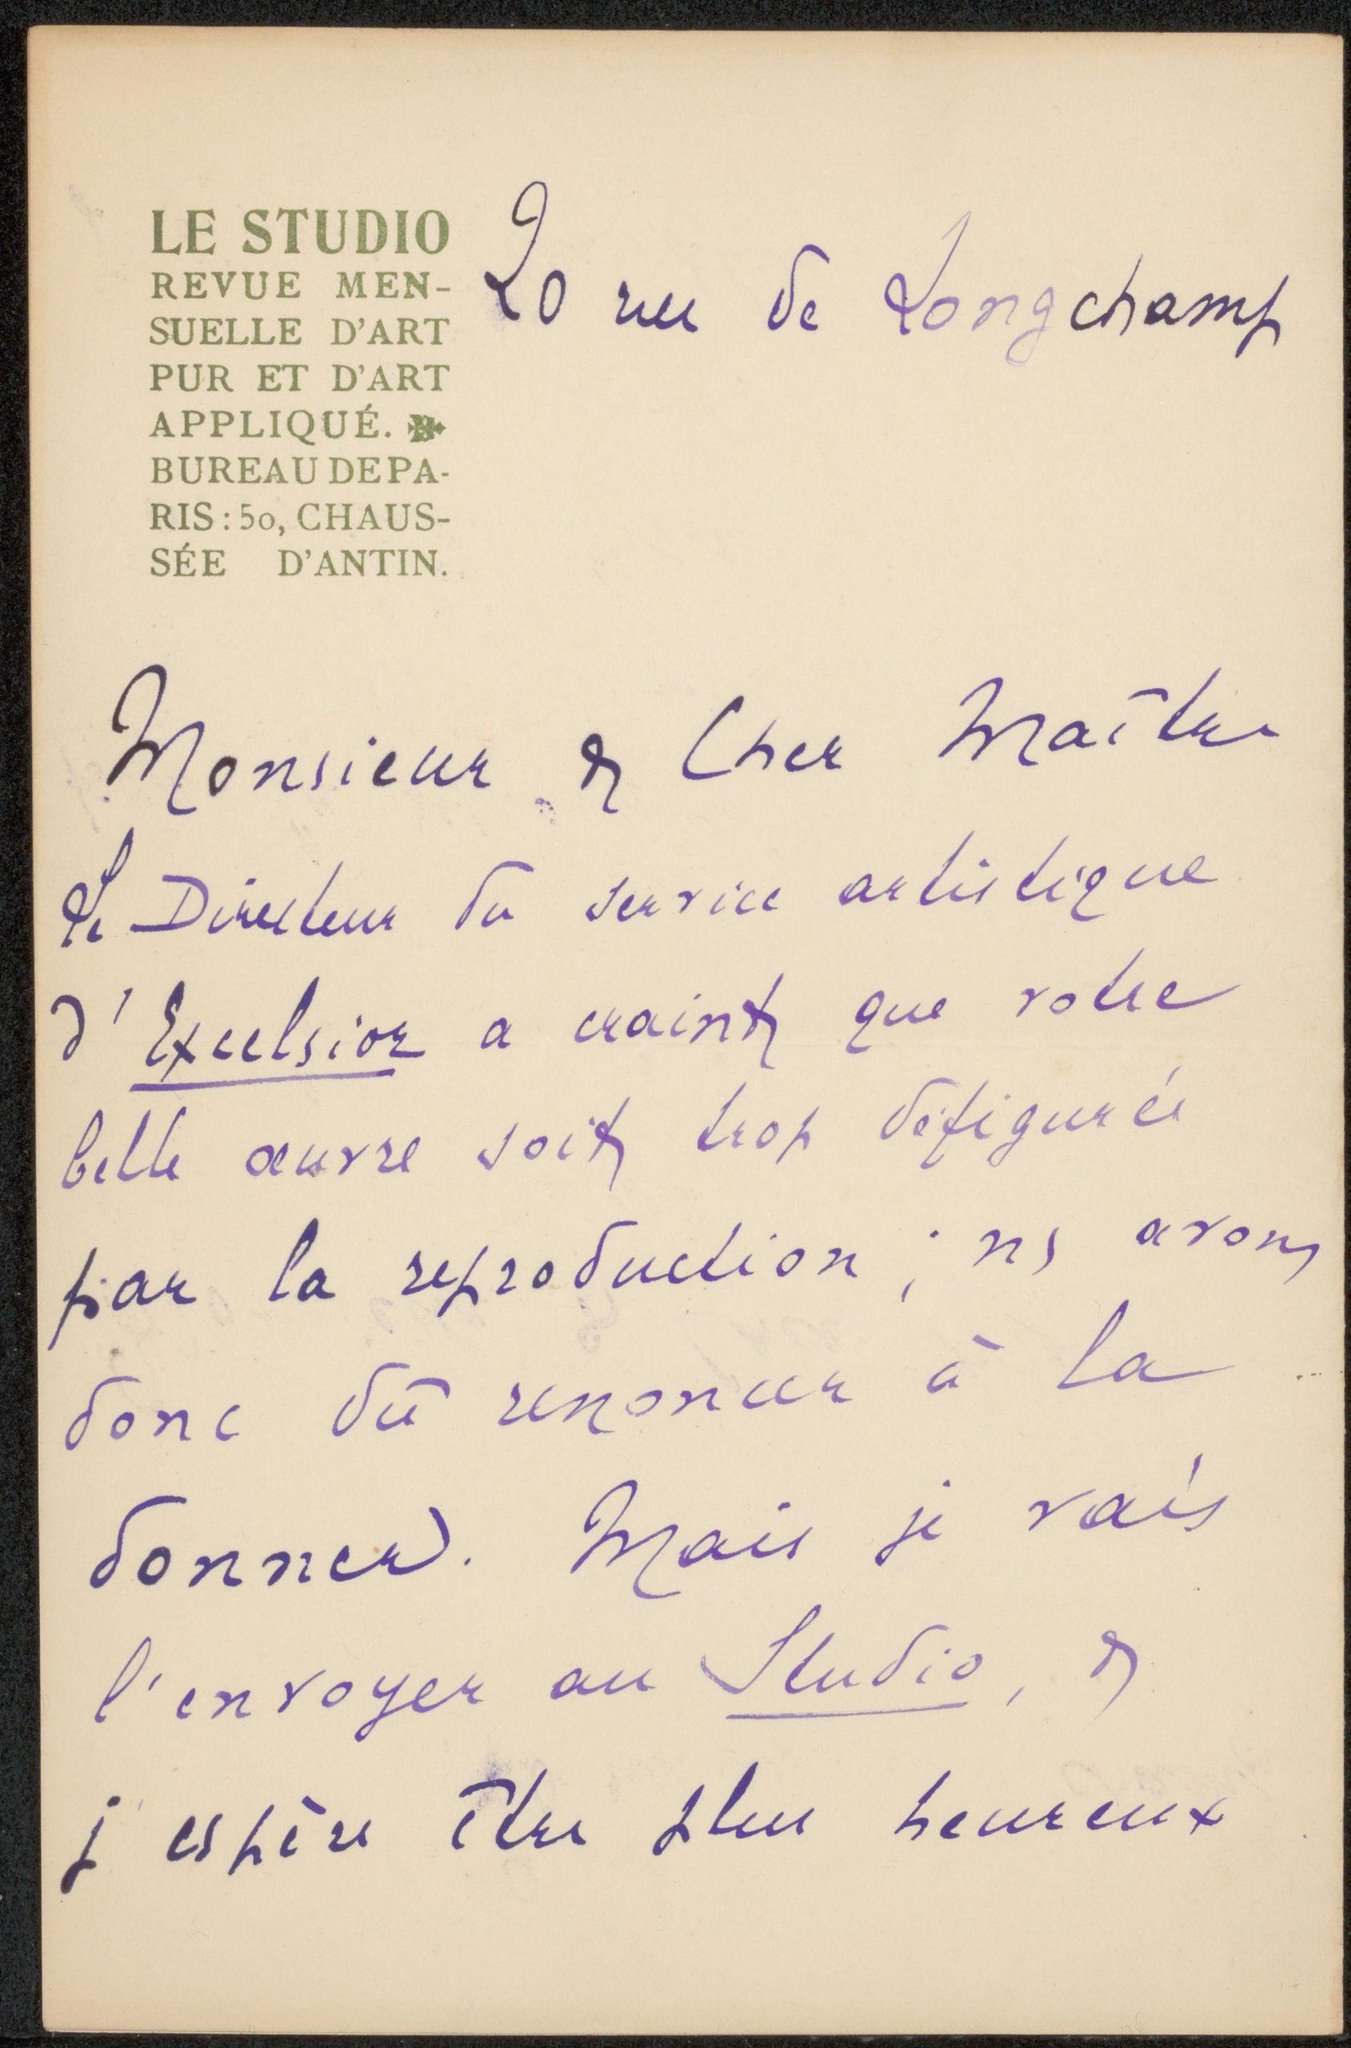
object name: letter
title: Brief aan Philip Zilcken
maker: henri frantz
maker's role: kunstcriticus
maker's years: 1870-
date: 1911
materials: ink, paper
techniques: pen, printing, writing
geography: paris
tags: the hague, painter, draughtsman, philip zilcken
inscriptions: collector's mark: ‘RPK’